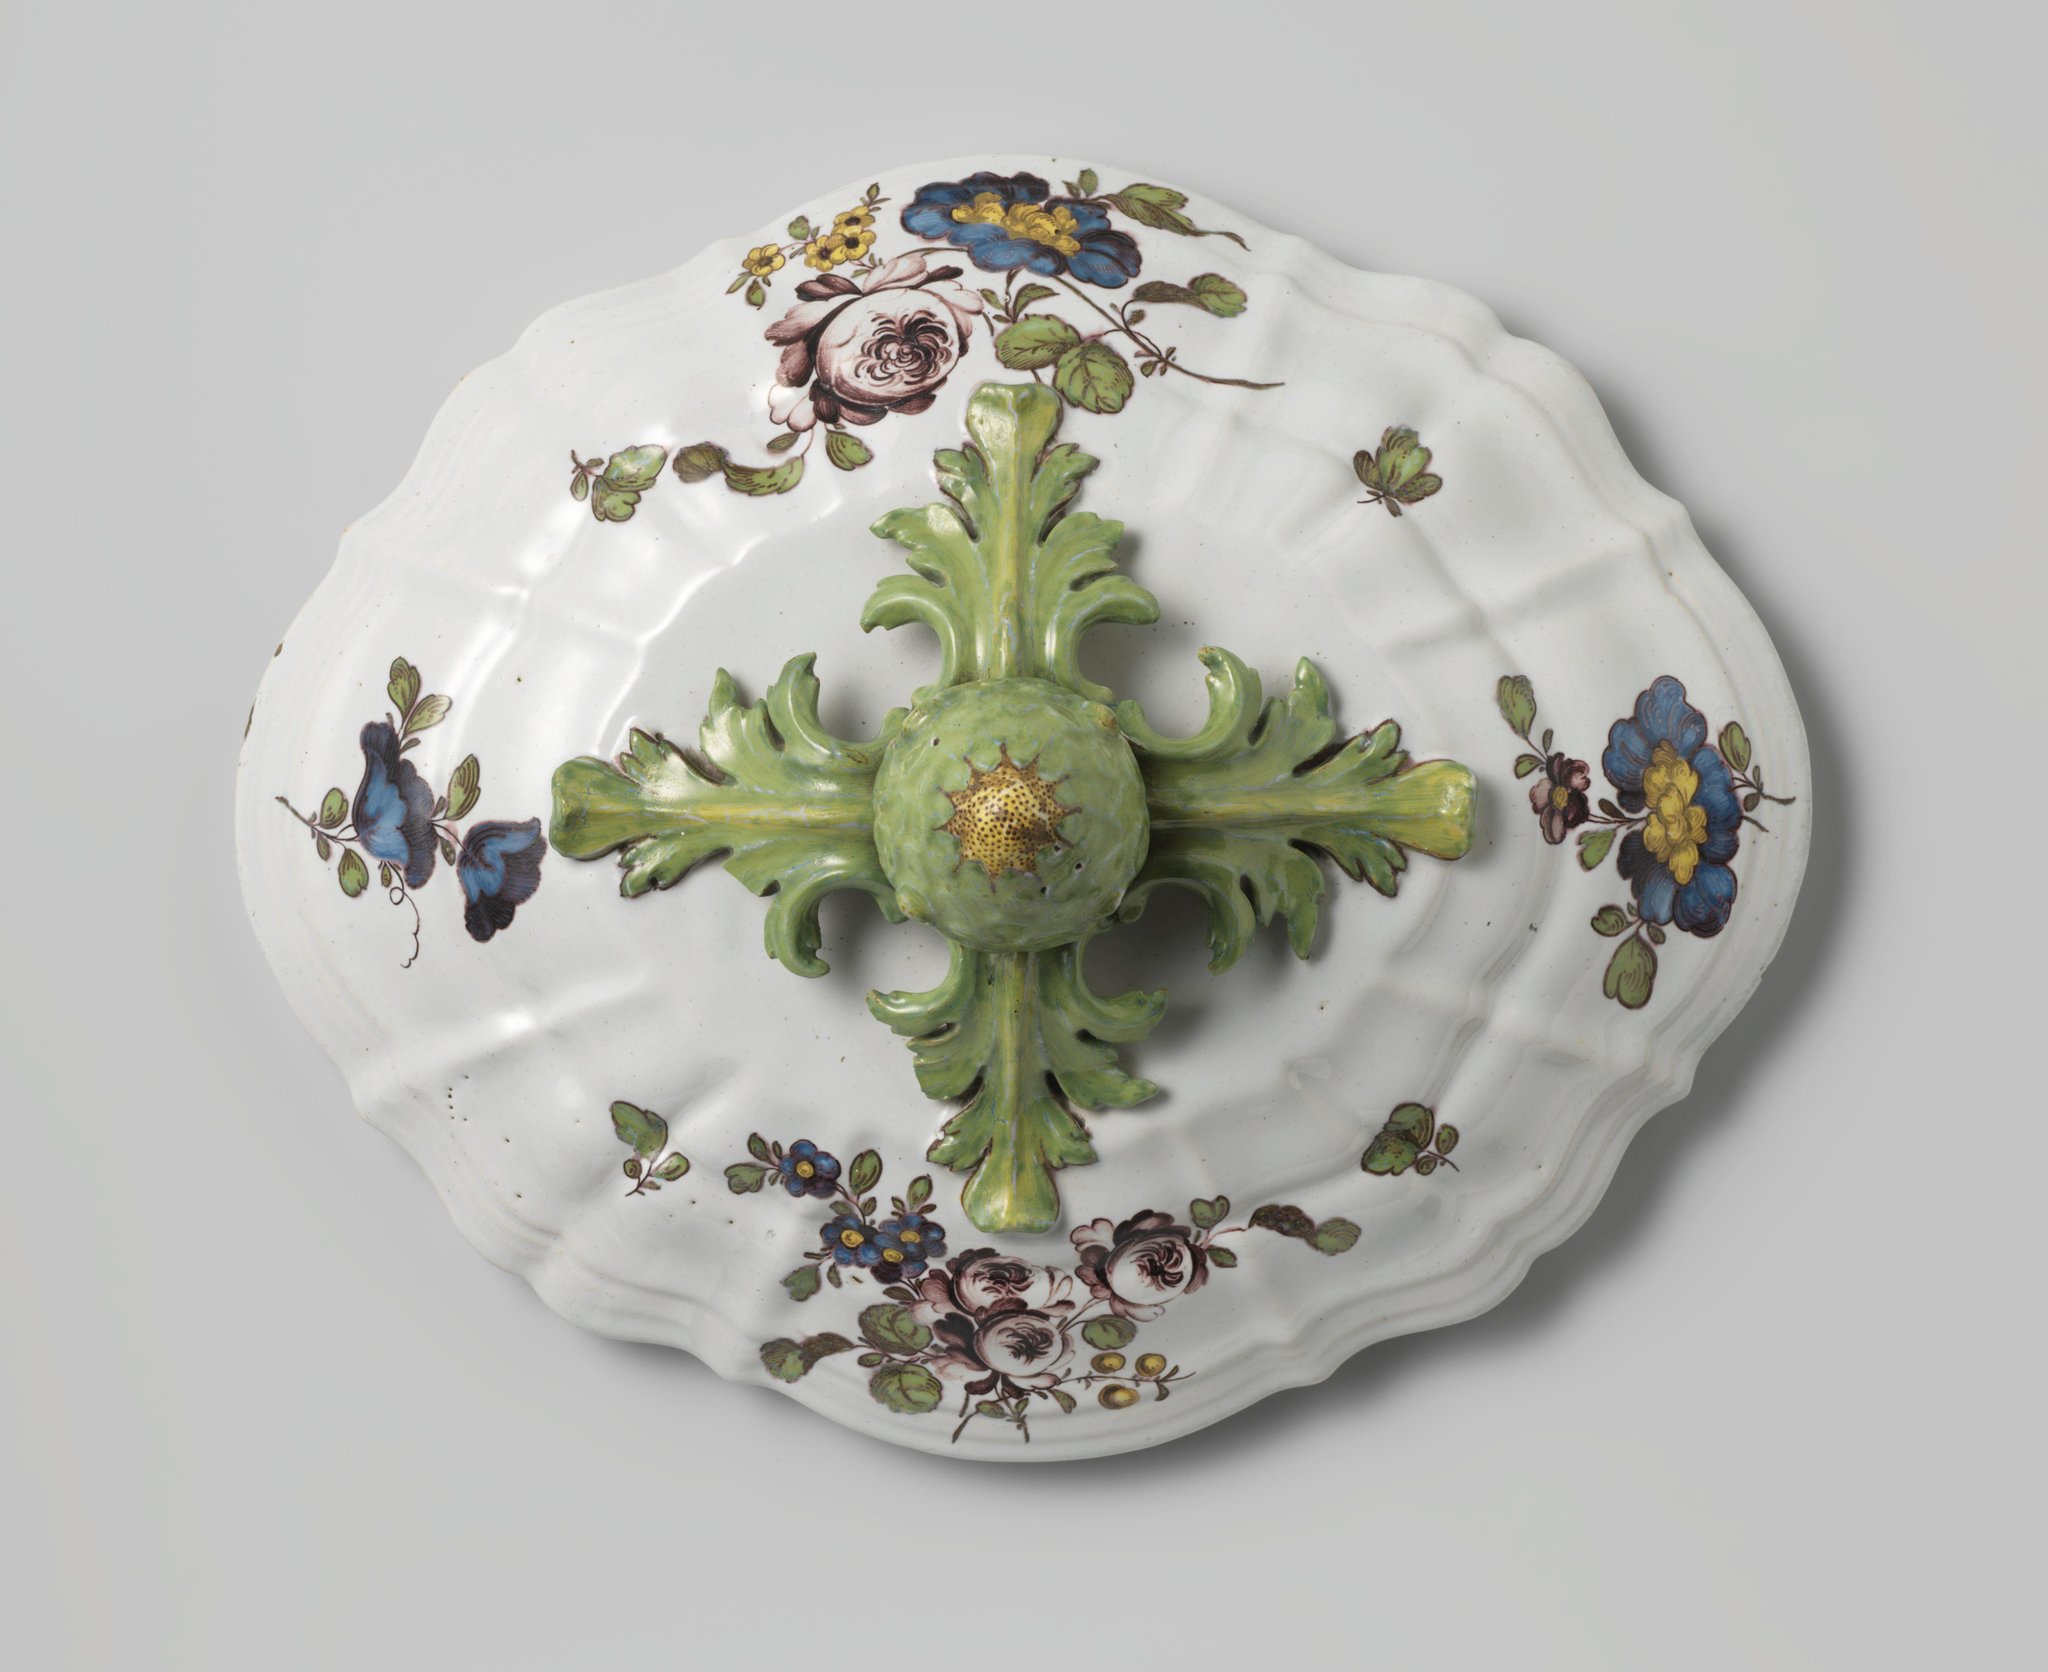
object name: lid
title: Deksel van terrine, veelkleurig beschilderd met bloemboeketten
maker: johan van kerkhoff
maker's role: fayencier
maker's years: 1716-1773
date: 1760-1770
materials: earthenware, glaze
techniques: painted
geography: arnhem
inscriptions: mark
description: Tureen and stand. Faience with petit feu decoration. Arnhem, c. 1760 - 1770. Factory of Johan van Kerckhoff.